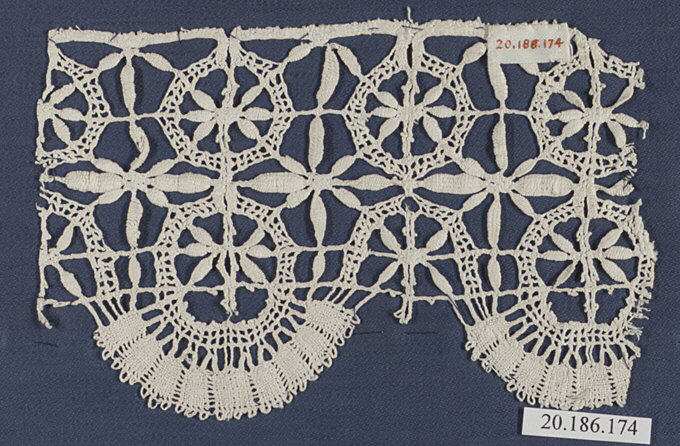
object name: edging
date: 1601-1700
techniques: lace